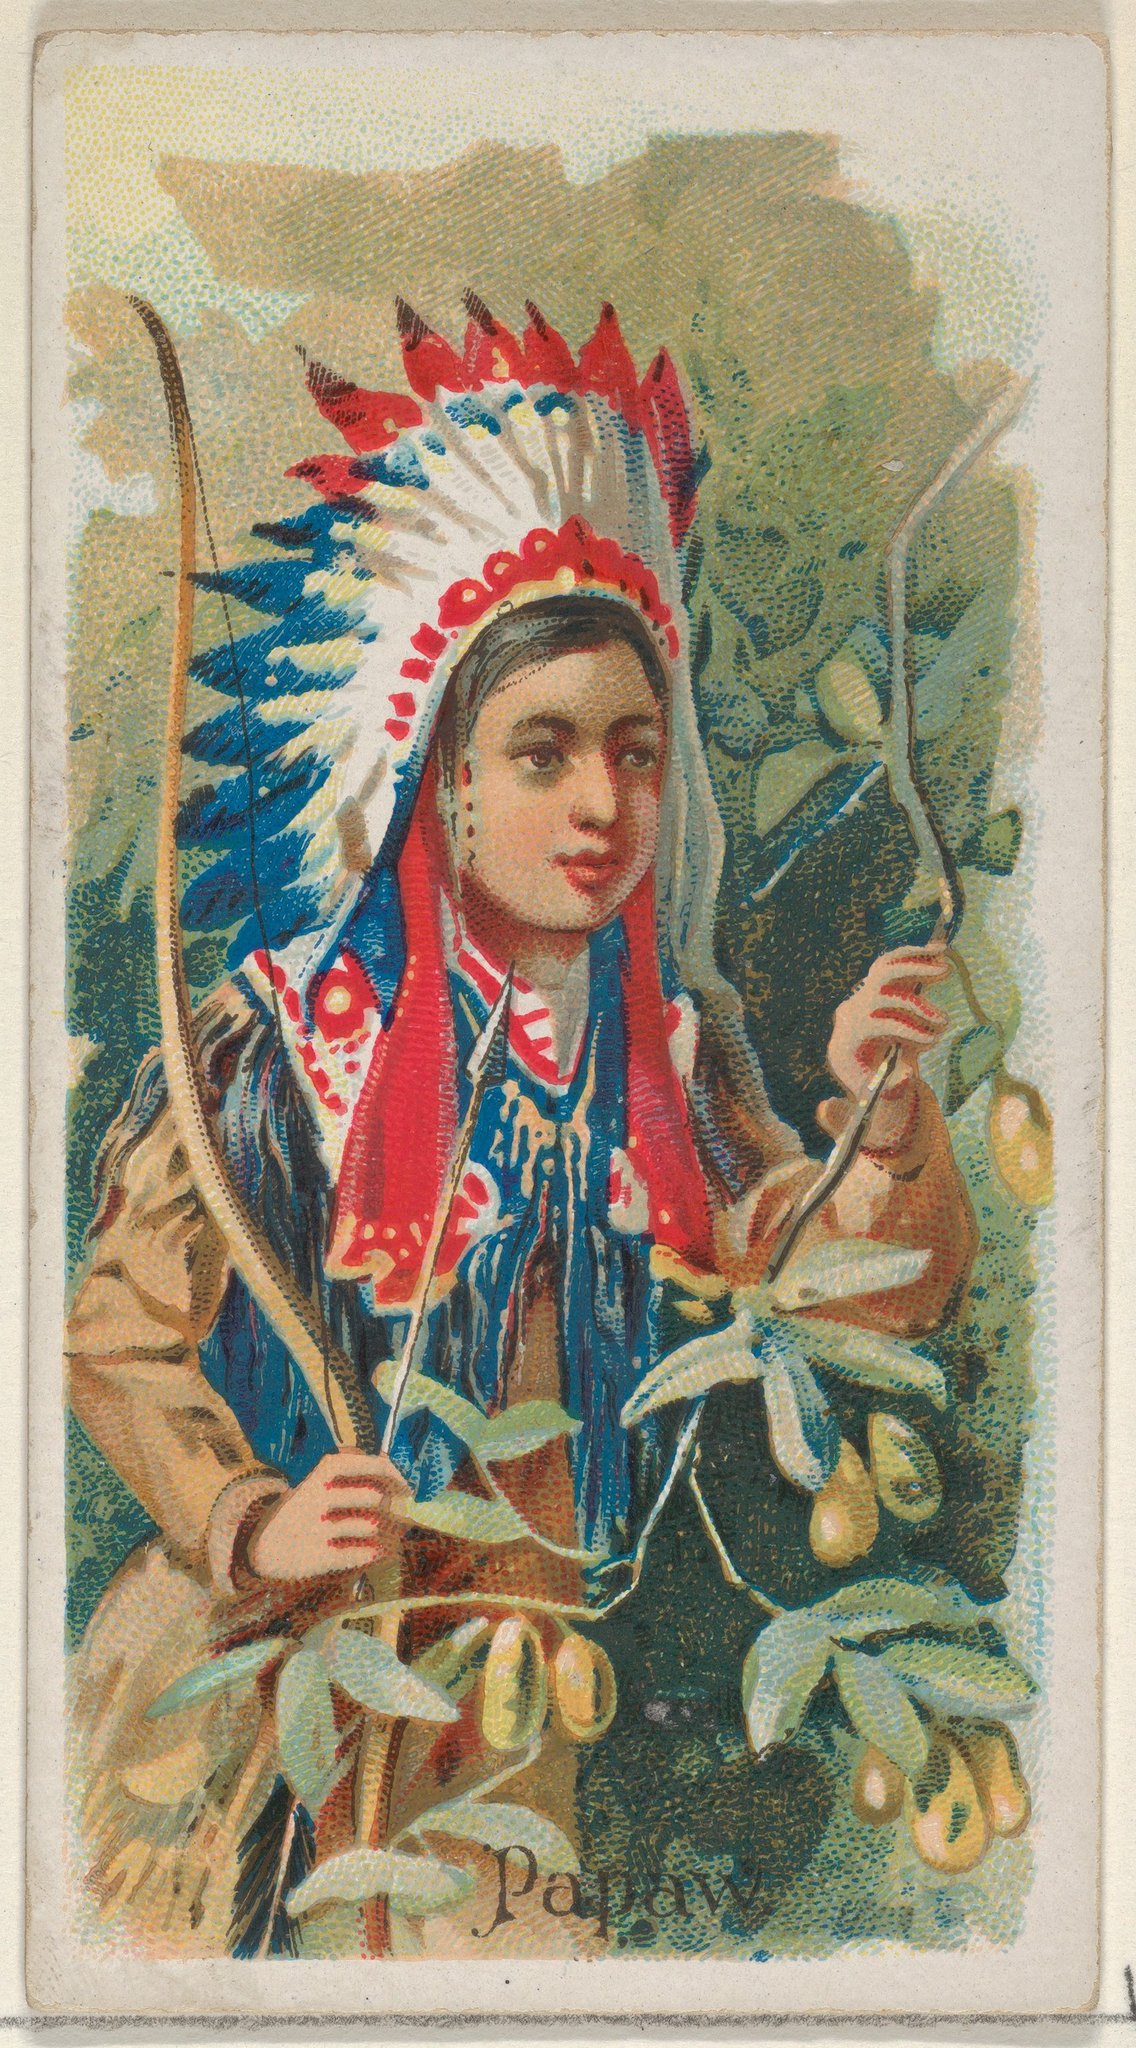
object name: print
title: Papaw, from the Fruits series (N12) for Allen & Ginter Cigarettes Brands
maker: allen & ginter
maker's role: publisher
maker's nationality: american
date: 1891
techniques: color lithograph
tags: bow and arrow,fruit,girls